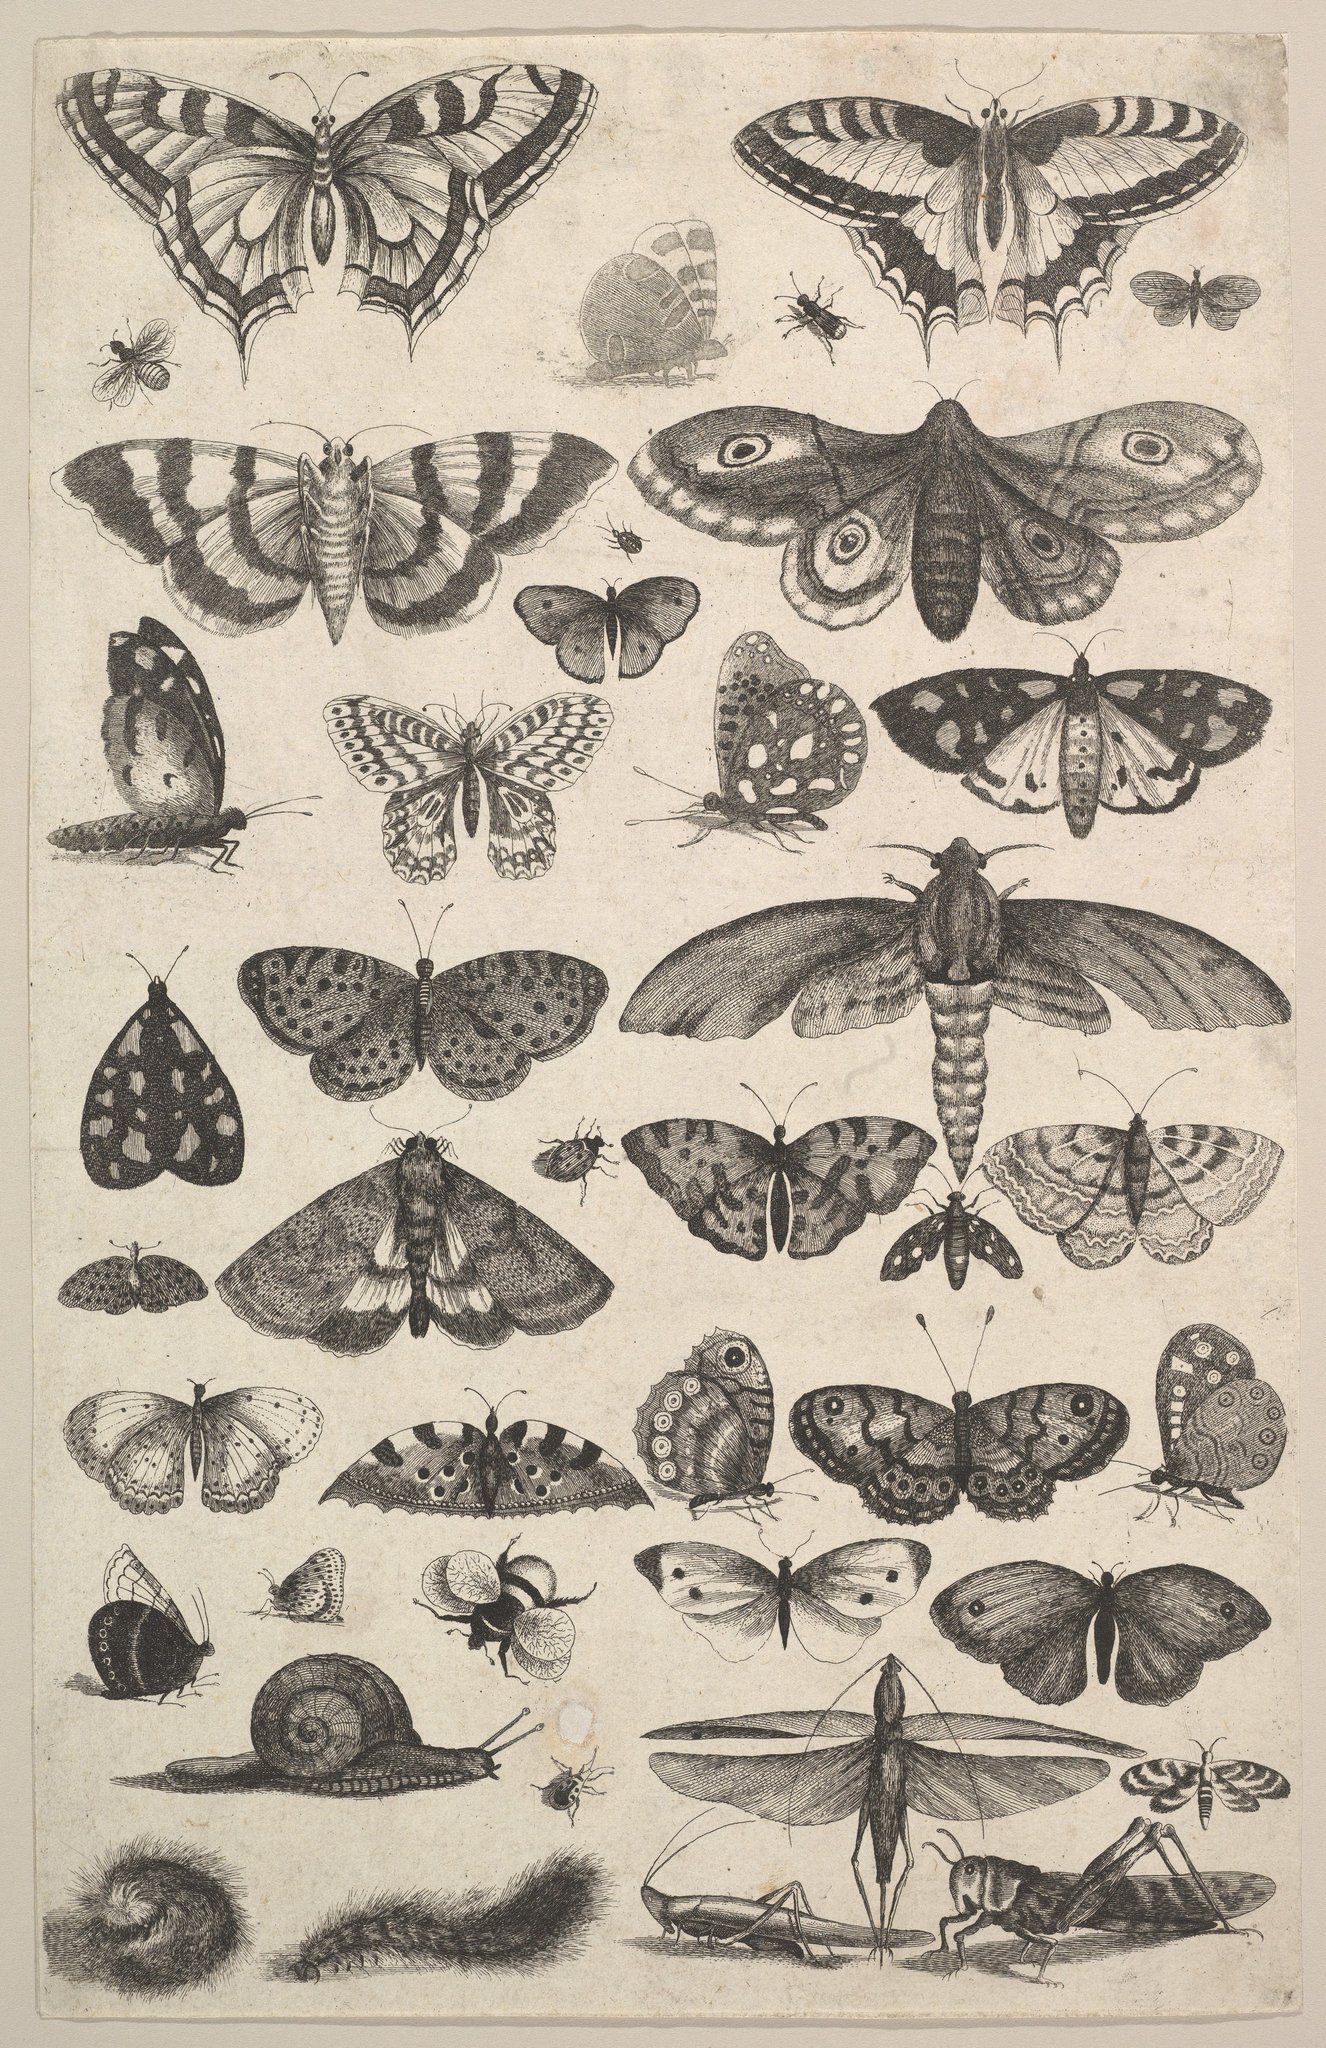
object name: print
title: Forty-one Insects, including moths and butterflies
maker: wenceslaus hollar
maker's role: artist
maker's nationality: bohemian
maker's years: 1607-1677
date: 1625-1677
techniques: etching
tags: insects,butterflies,snails